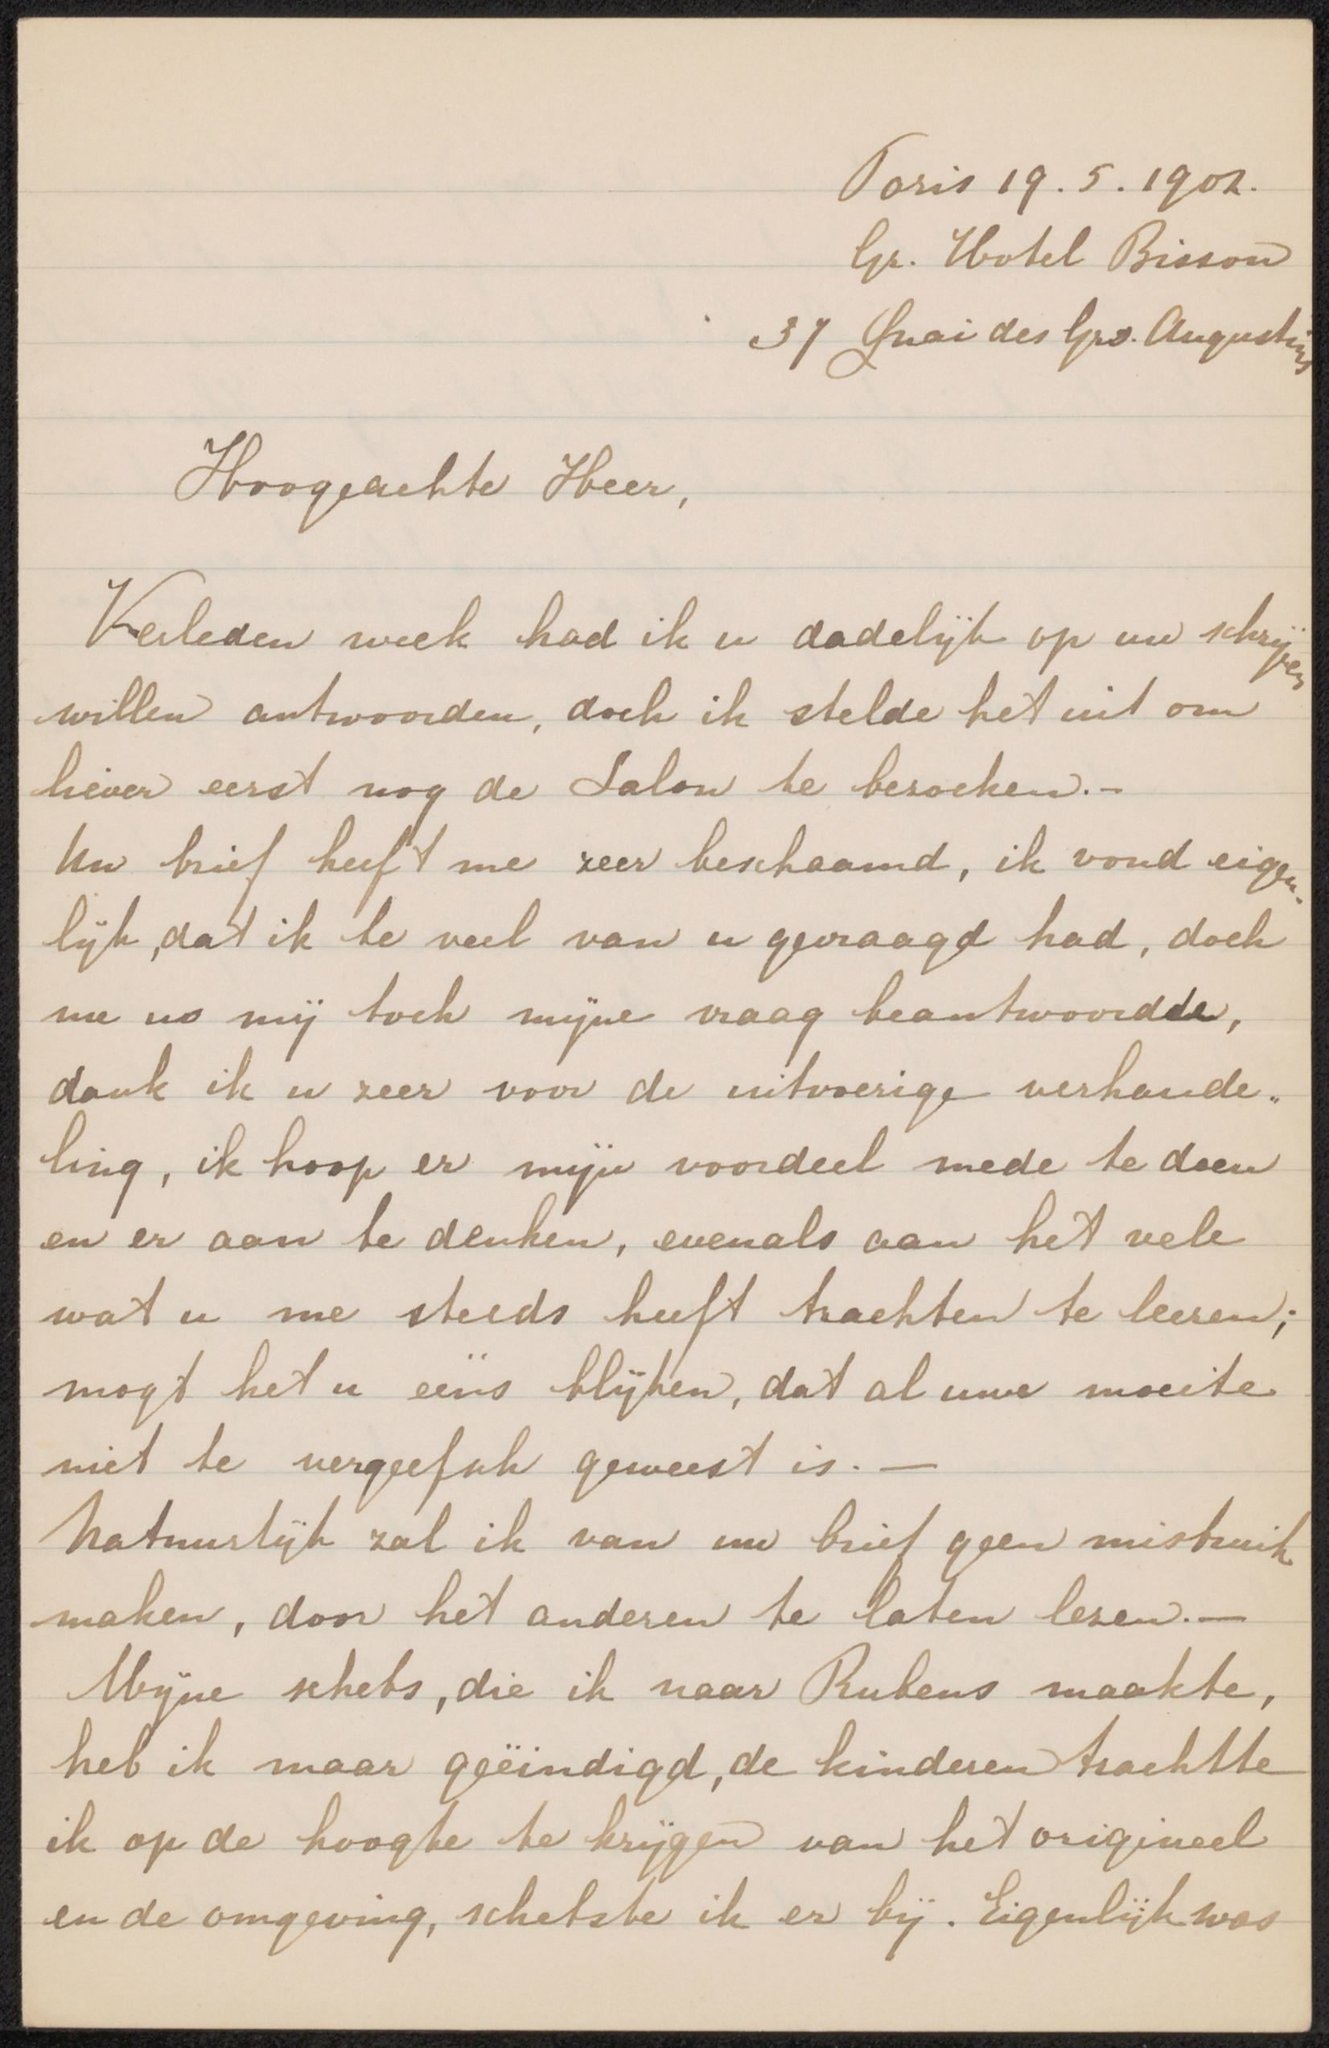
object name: letter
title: Brief aan August Allebé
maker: betsy van manen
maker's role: print maker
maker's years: 1873-1915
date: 1902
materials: ink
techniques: pen, writing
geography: paris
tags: print maker, draughtsman, august allebé, léon bonnat, agnieta cornelia gijswijt, antwerp, peter paul rubens, paris, painter, françois émile michel, anonymous historical person portrayed, exhibition ~ art, artist at work, in his workshop - bb - out of doors